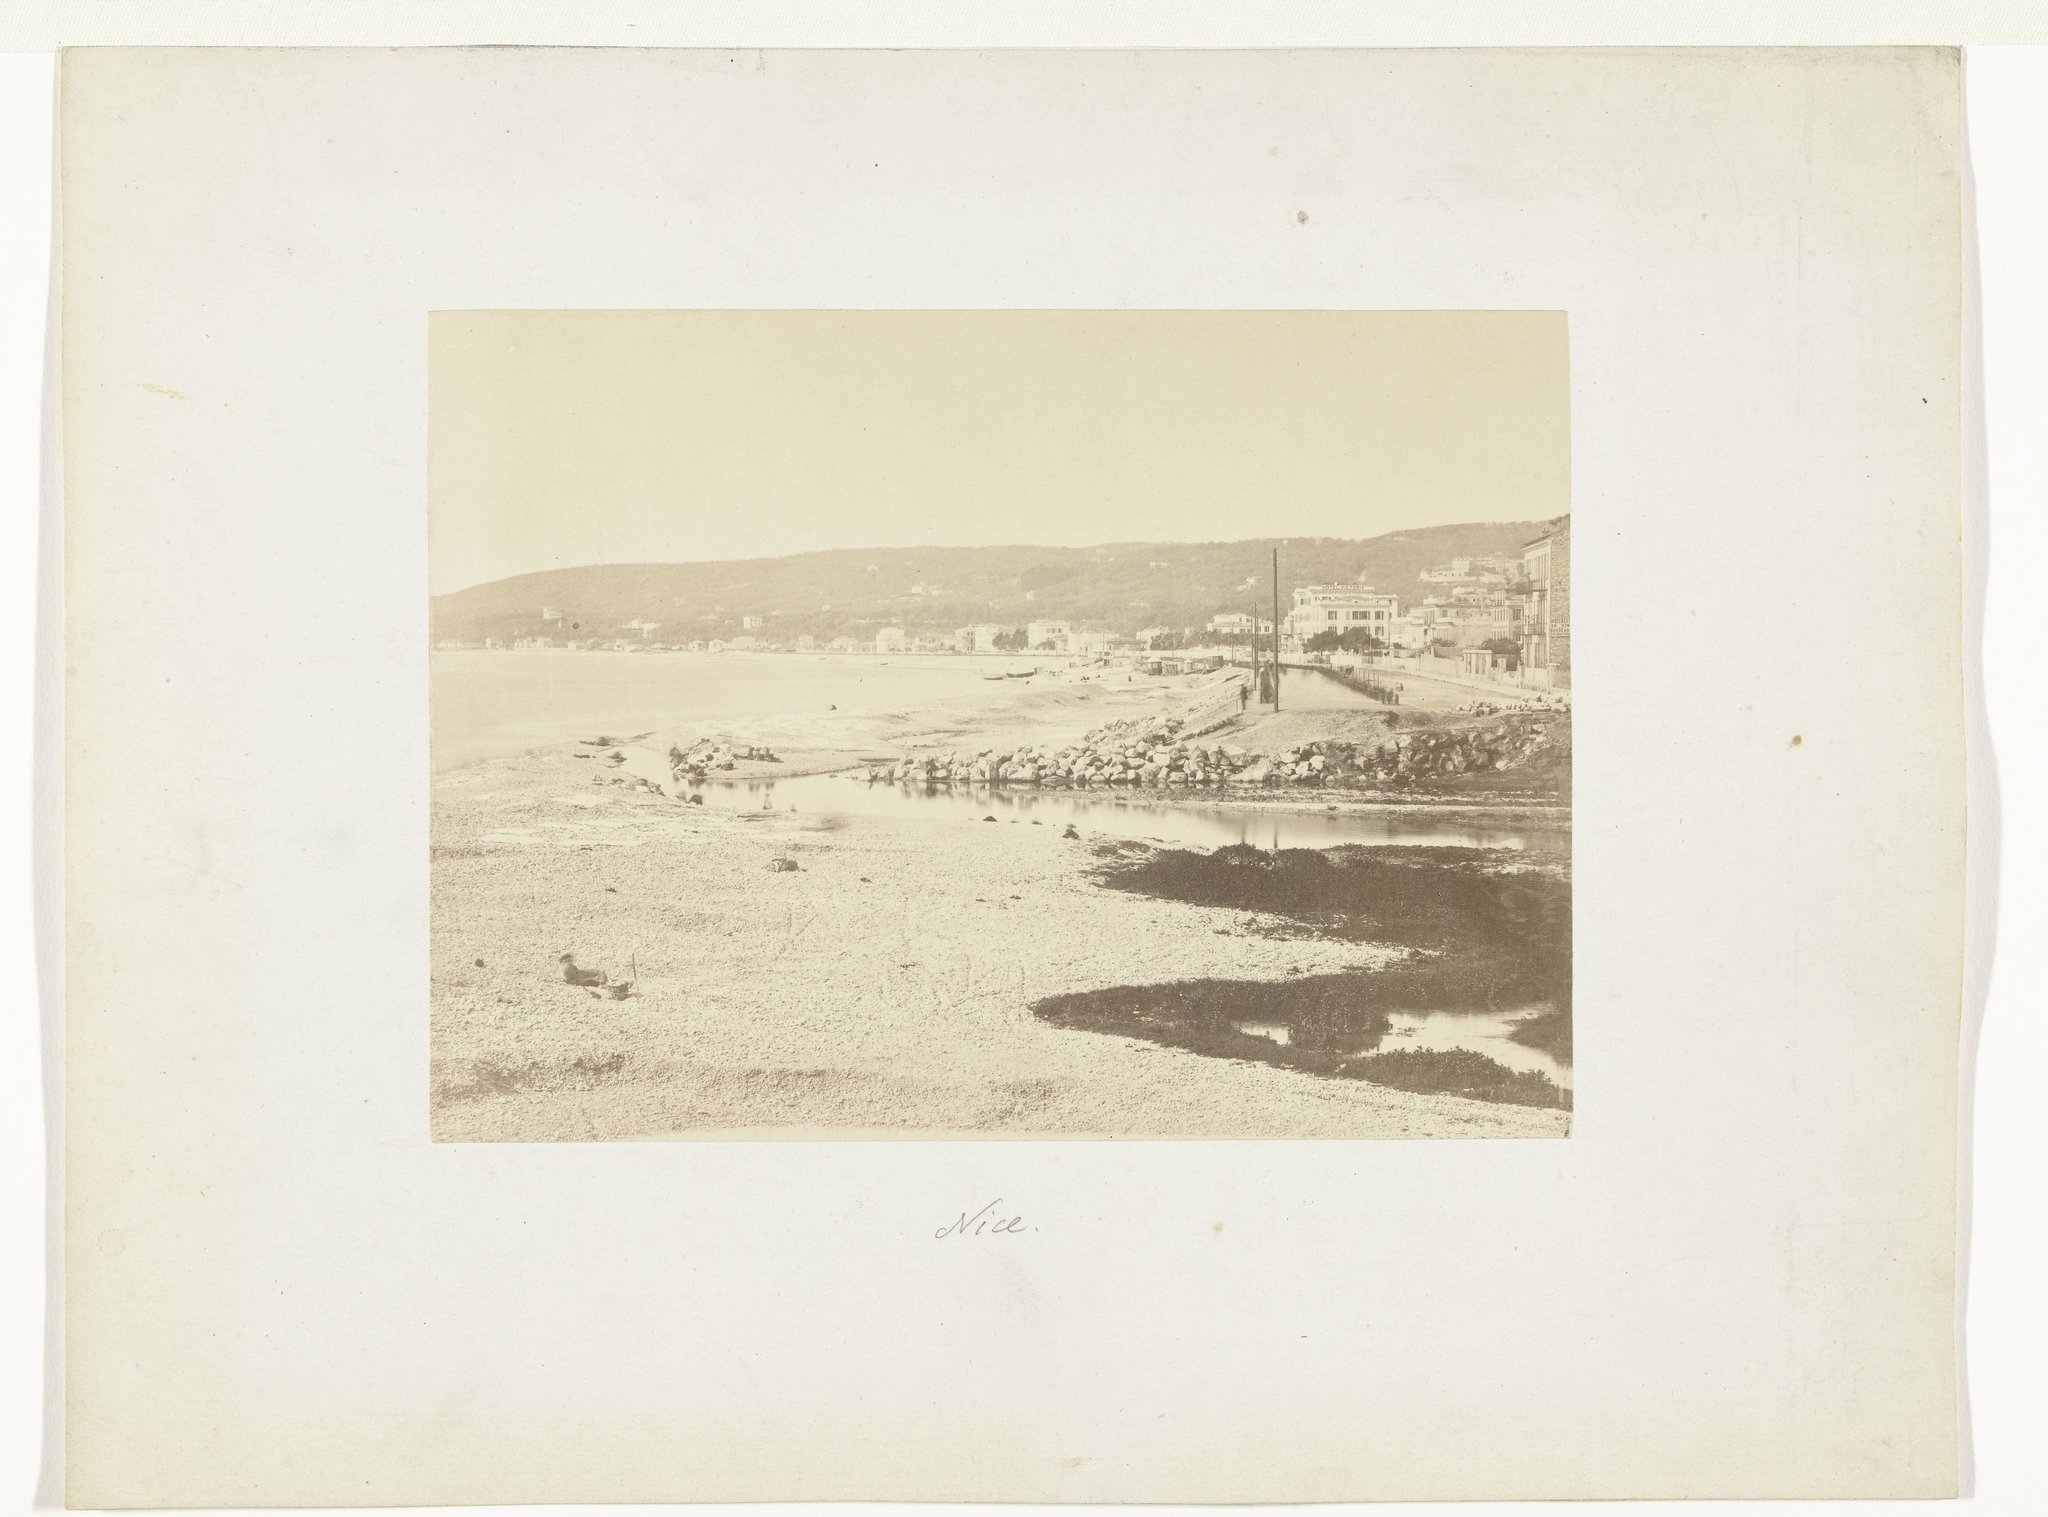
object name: photograph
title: Strand bij Nice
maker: louis crette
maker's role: fotograaf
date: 1862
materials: cardboard, paper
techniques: albumen print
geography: nice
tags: coast, beach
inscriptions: inscription: ‘Nice’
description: Strand bij Nice met de Promenade des Anglais.